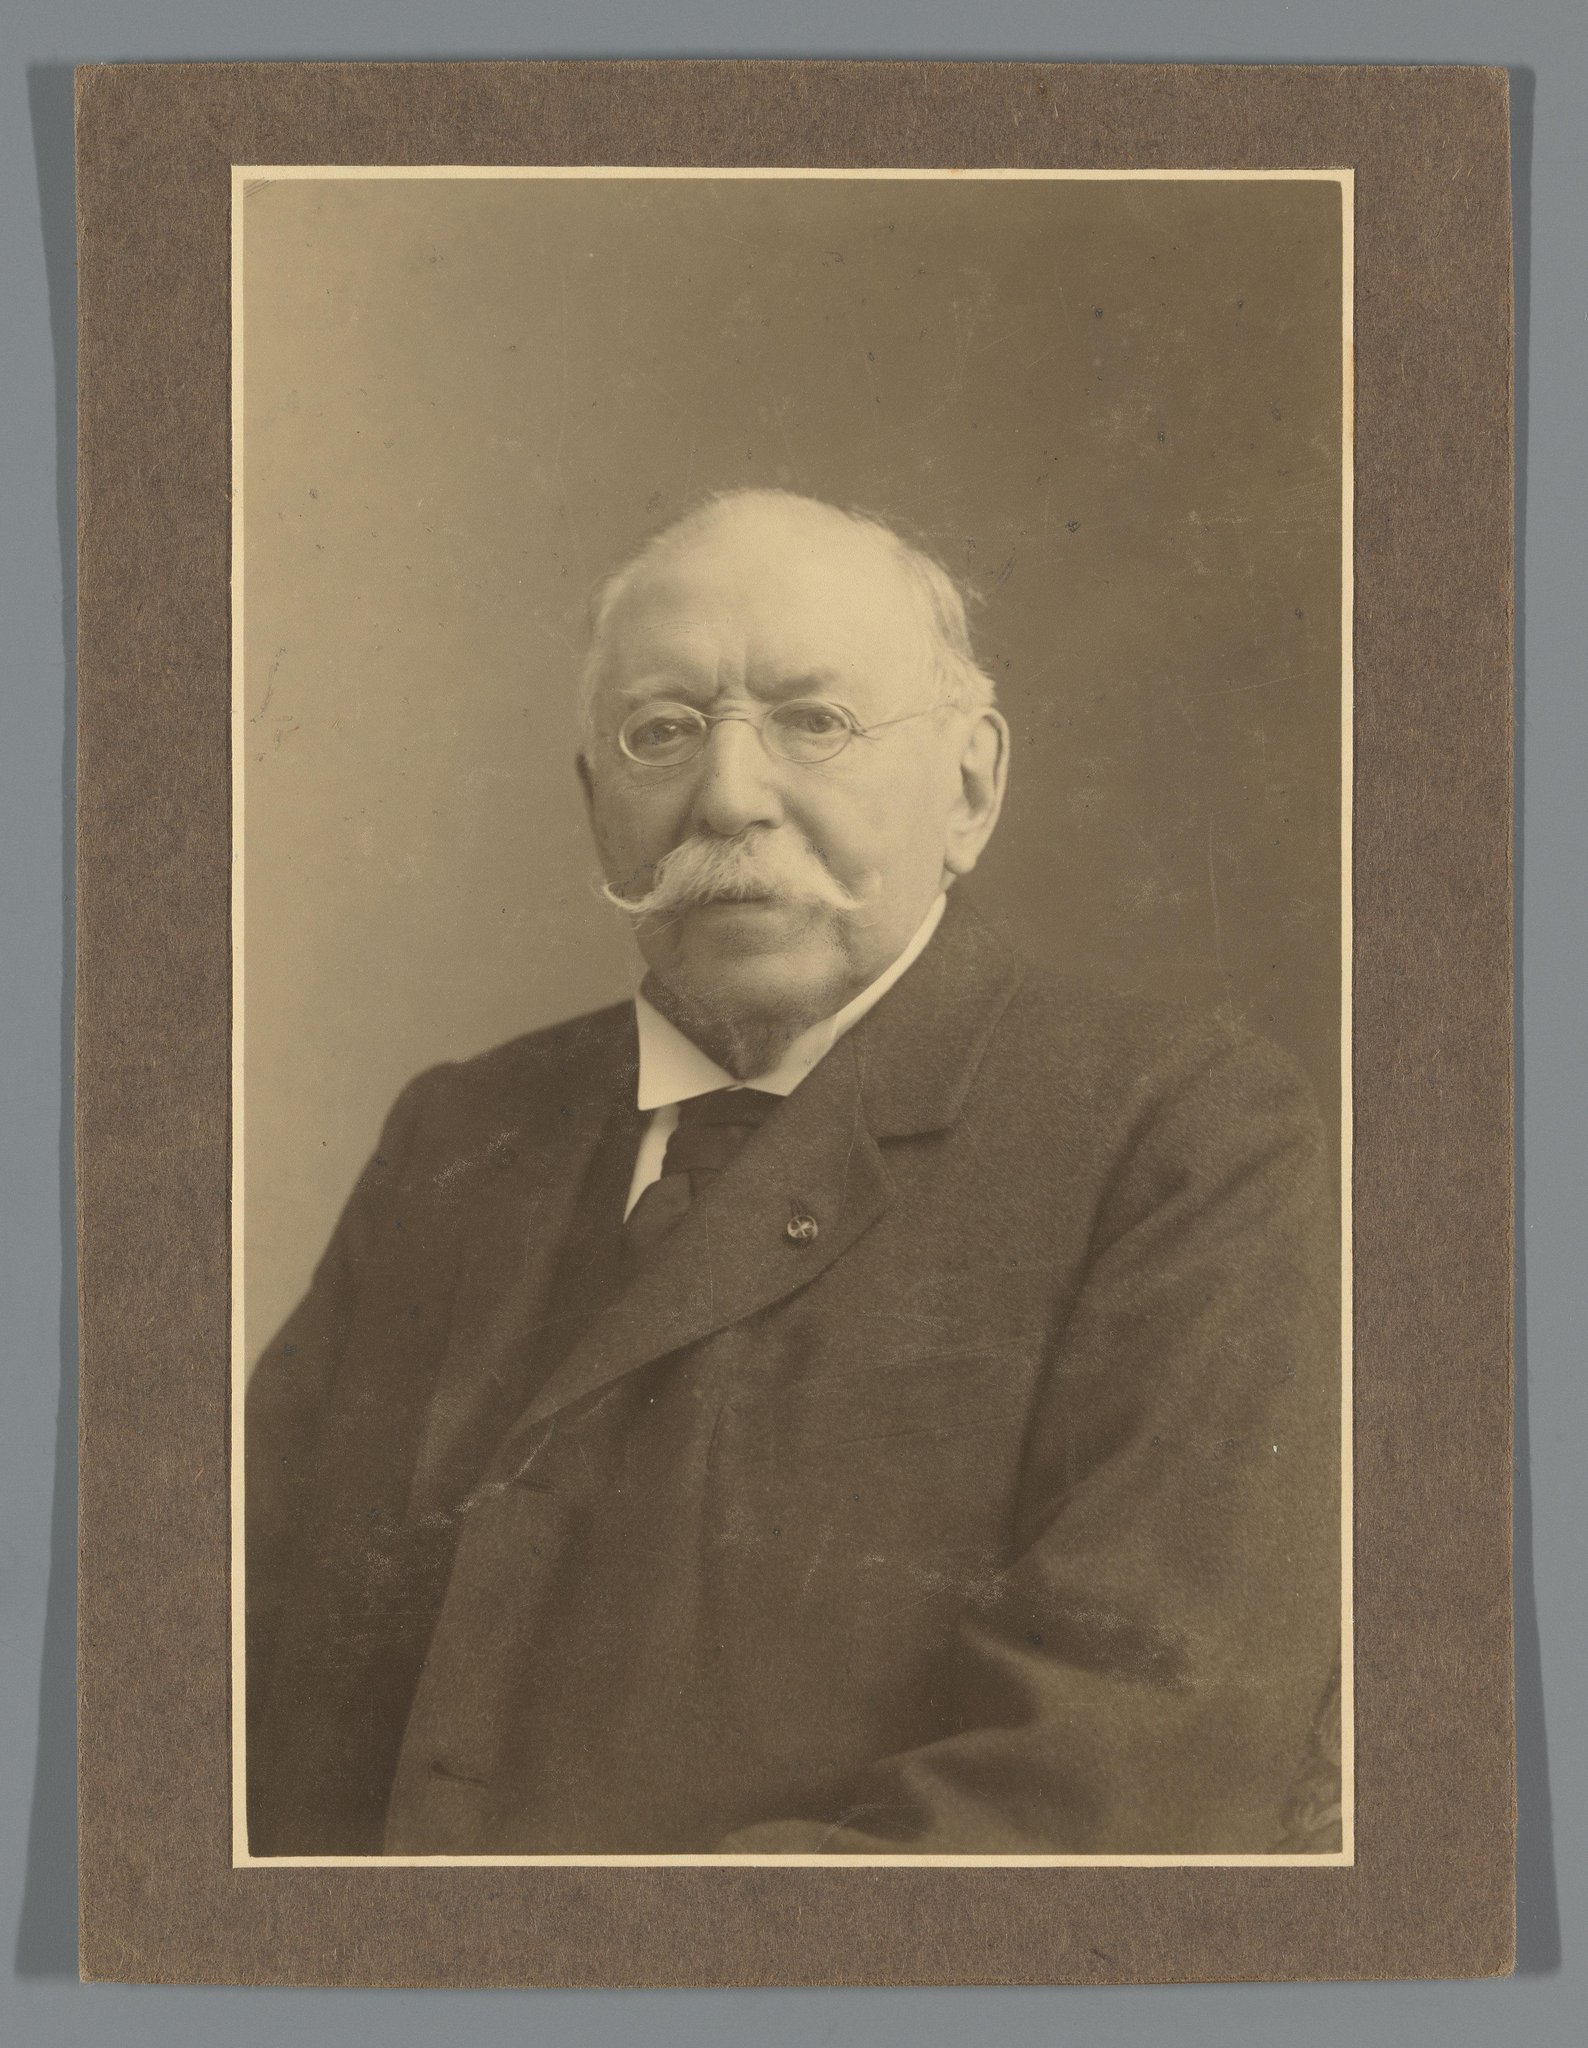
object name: photograph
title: Portret van Norbert van den Berg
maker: Anonymous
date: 1855-1910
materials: cardboard, photographic support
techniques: albumen print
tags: rotterdam, amsterdam, norbertus petrus van den berg (1831-1917)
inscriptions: inscription: ‘N.P. van den Berg’